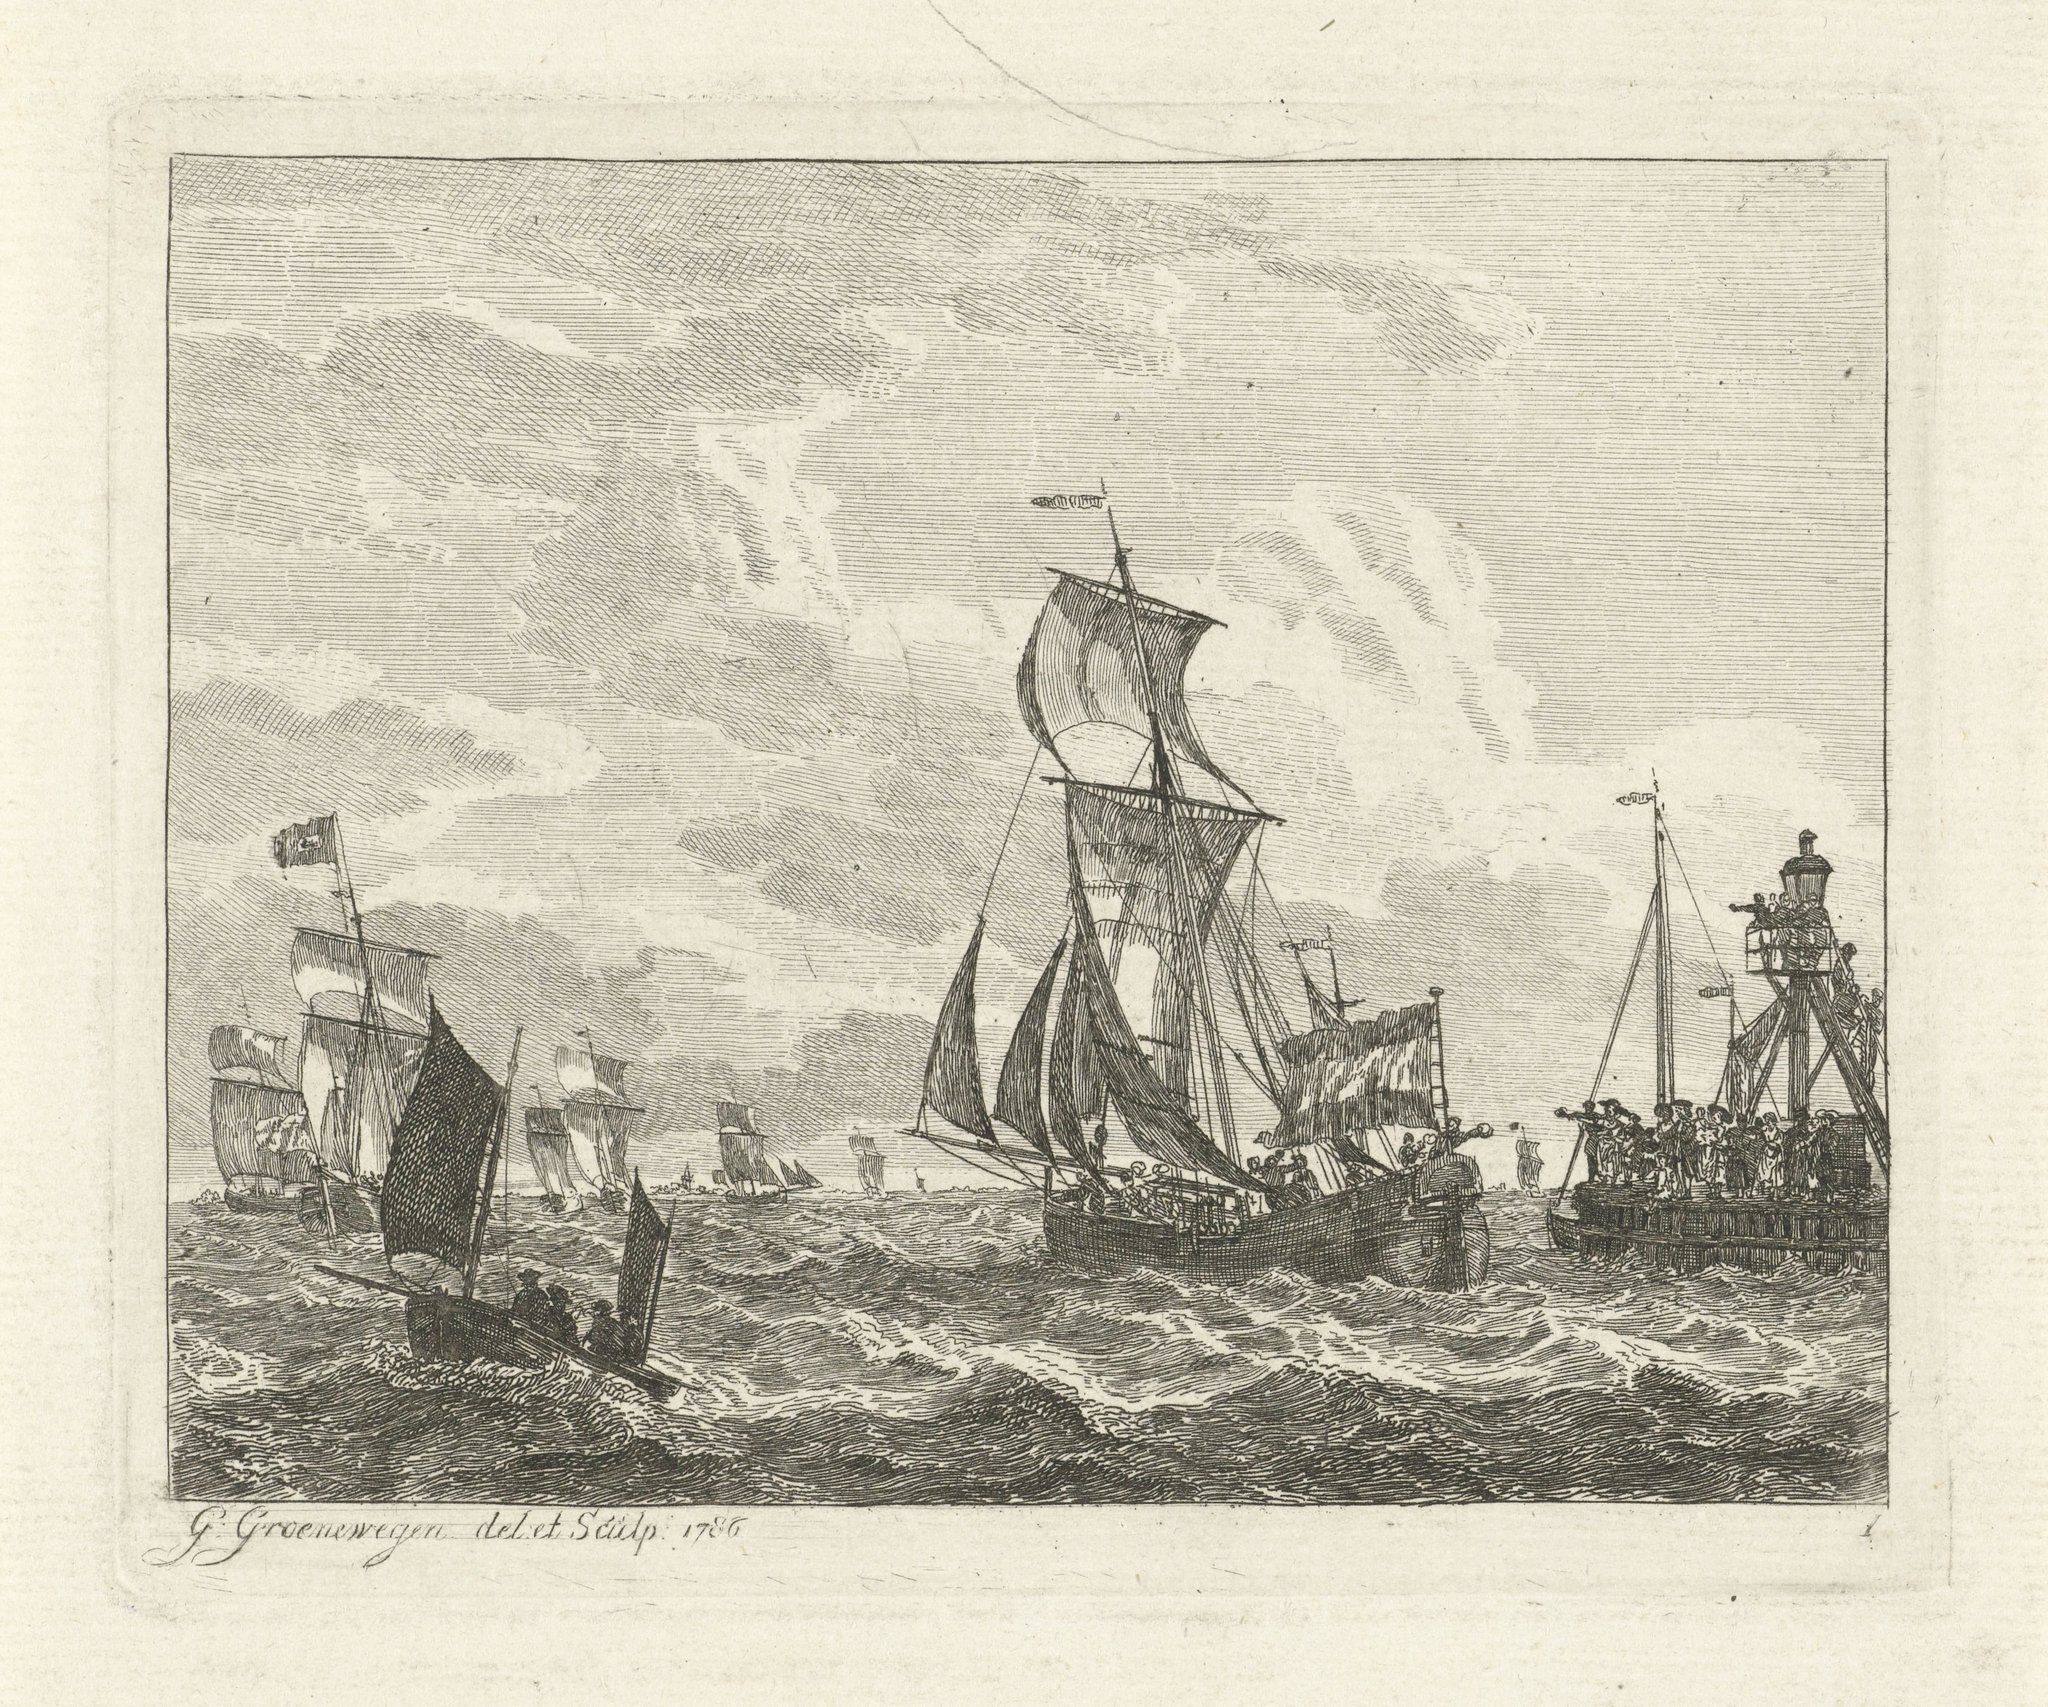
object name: print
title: Zeegezichten met schepen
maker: gerrit groenewegen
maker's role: draughtsman, print maker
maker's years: 1754-1826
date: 1786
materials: paper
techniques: etching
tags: ships (in general)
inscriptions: collector's mark: Lugt 2228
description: Diverse zeilschepen op een ruige zee. Aan de rechterzijde een stijger waarop vele figuren staan te zwaaien. Deze prent maakt deel uit van een serie van zes prenten met verschillende zeilschepen op zee. Onder in de marge rechts: 1.